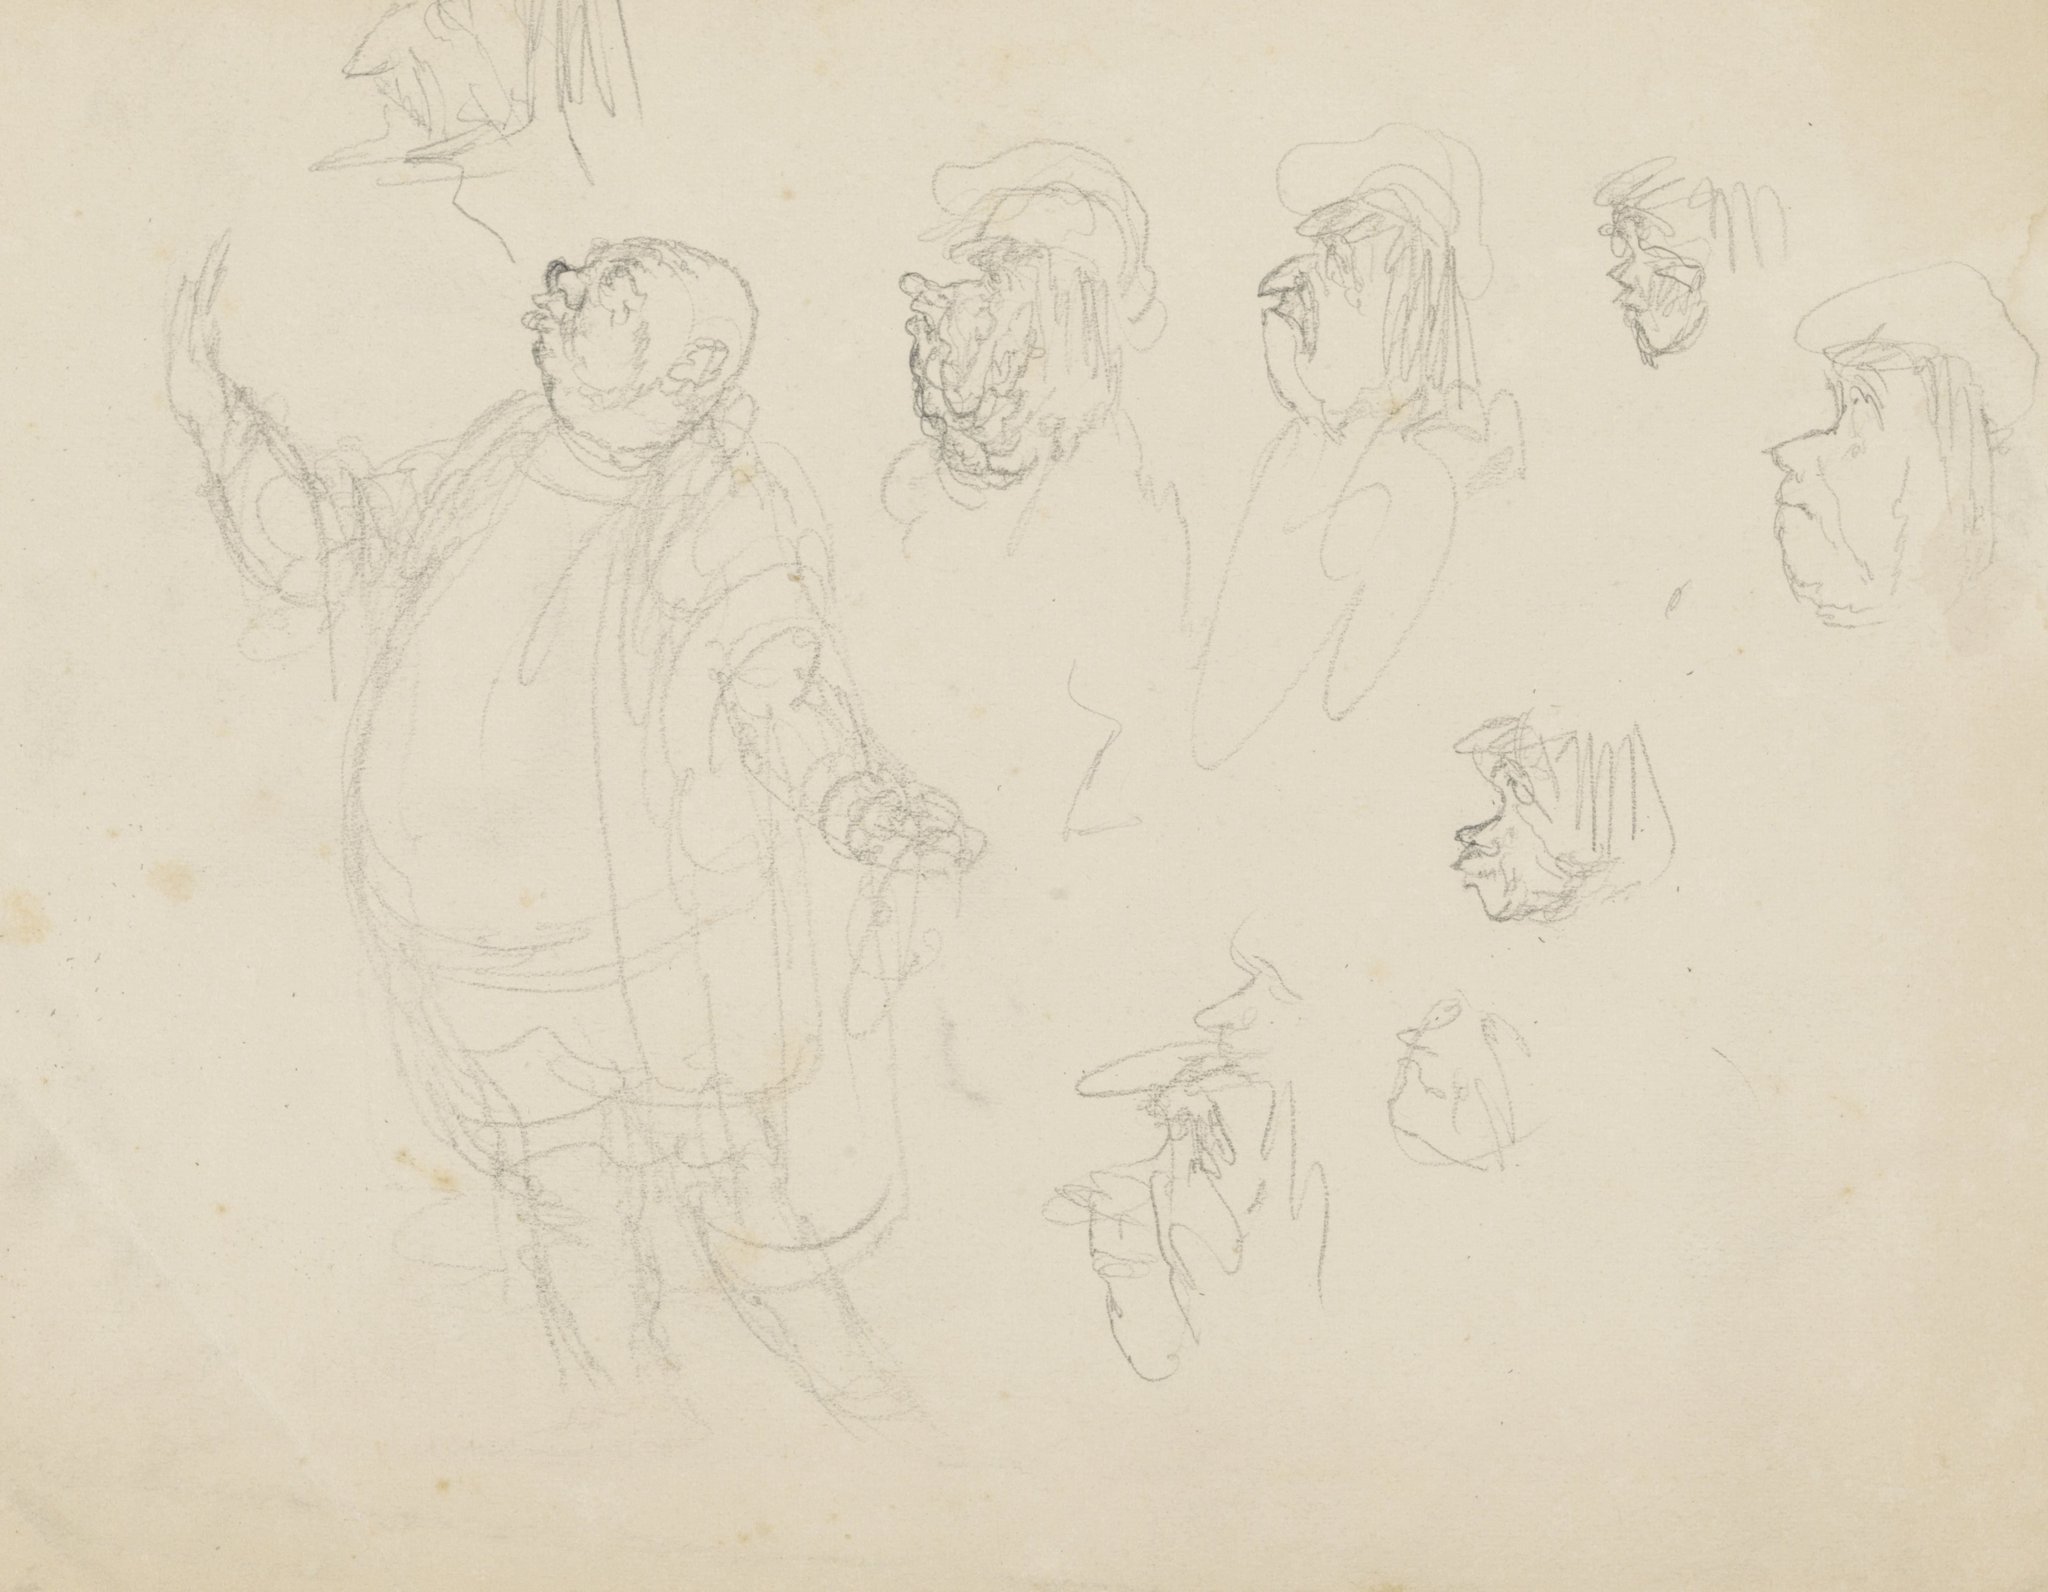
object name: drawing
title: Staande man en verschillende gezichten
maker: henk henriët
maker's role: draughtsman, print maker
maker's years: 1903-1945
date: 1936-1940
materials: paper, pencil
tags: face, caricatures (human types), standing figure (canon, proportions)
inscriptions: collector's mark: Lugt 2228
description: Deze tekening is mogelijk een ontwerp voor een illustratie bij het boek 'Gargantua en Pantagruel' van François Rabelais.